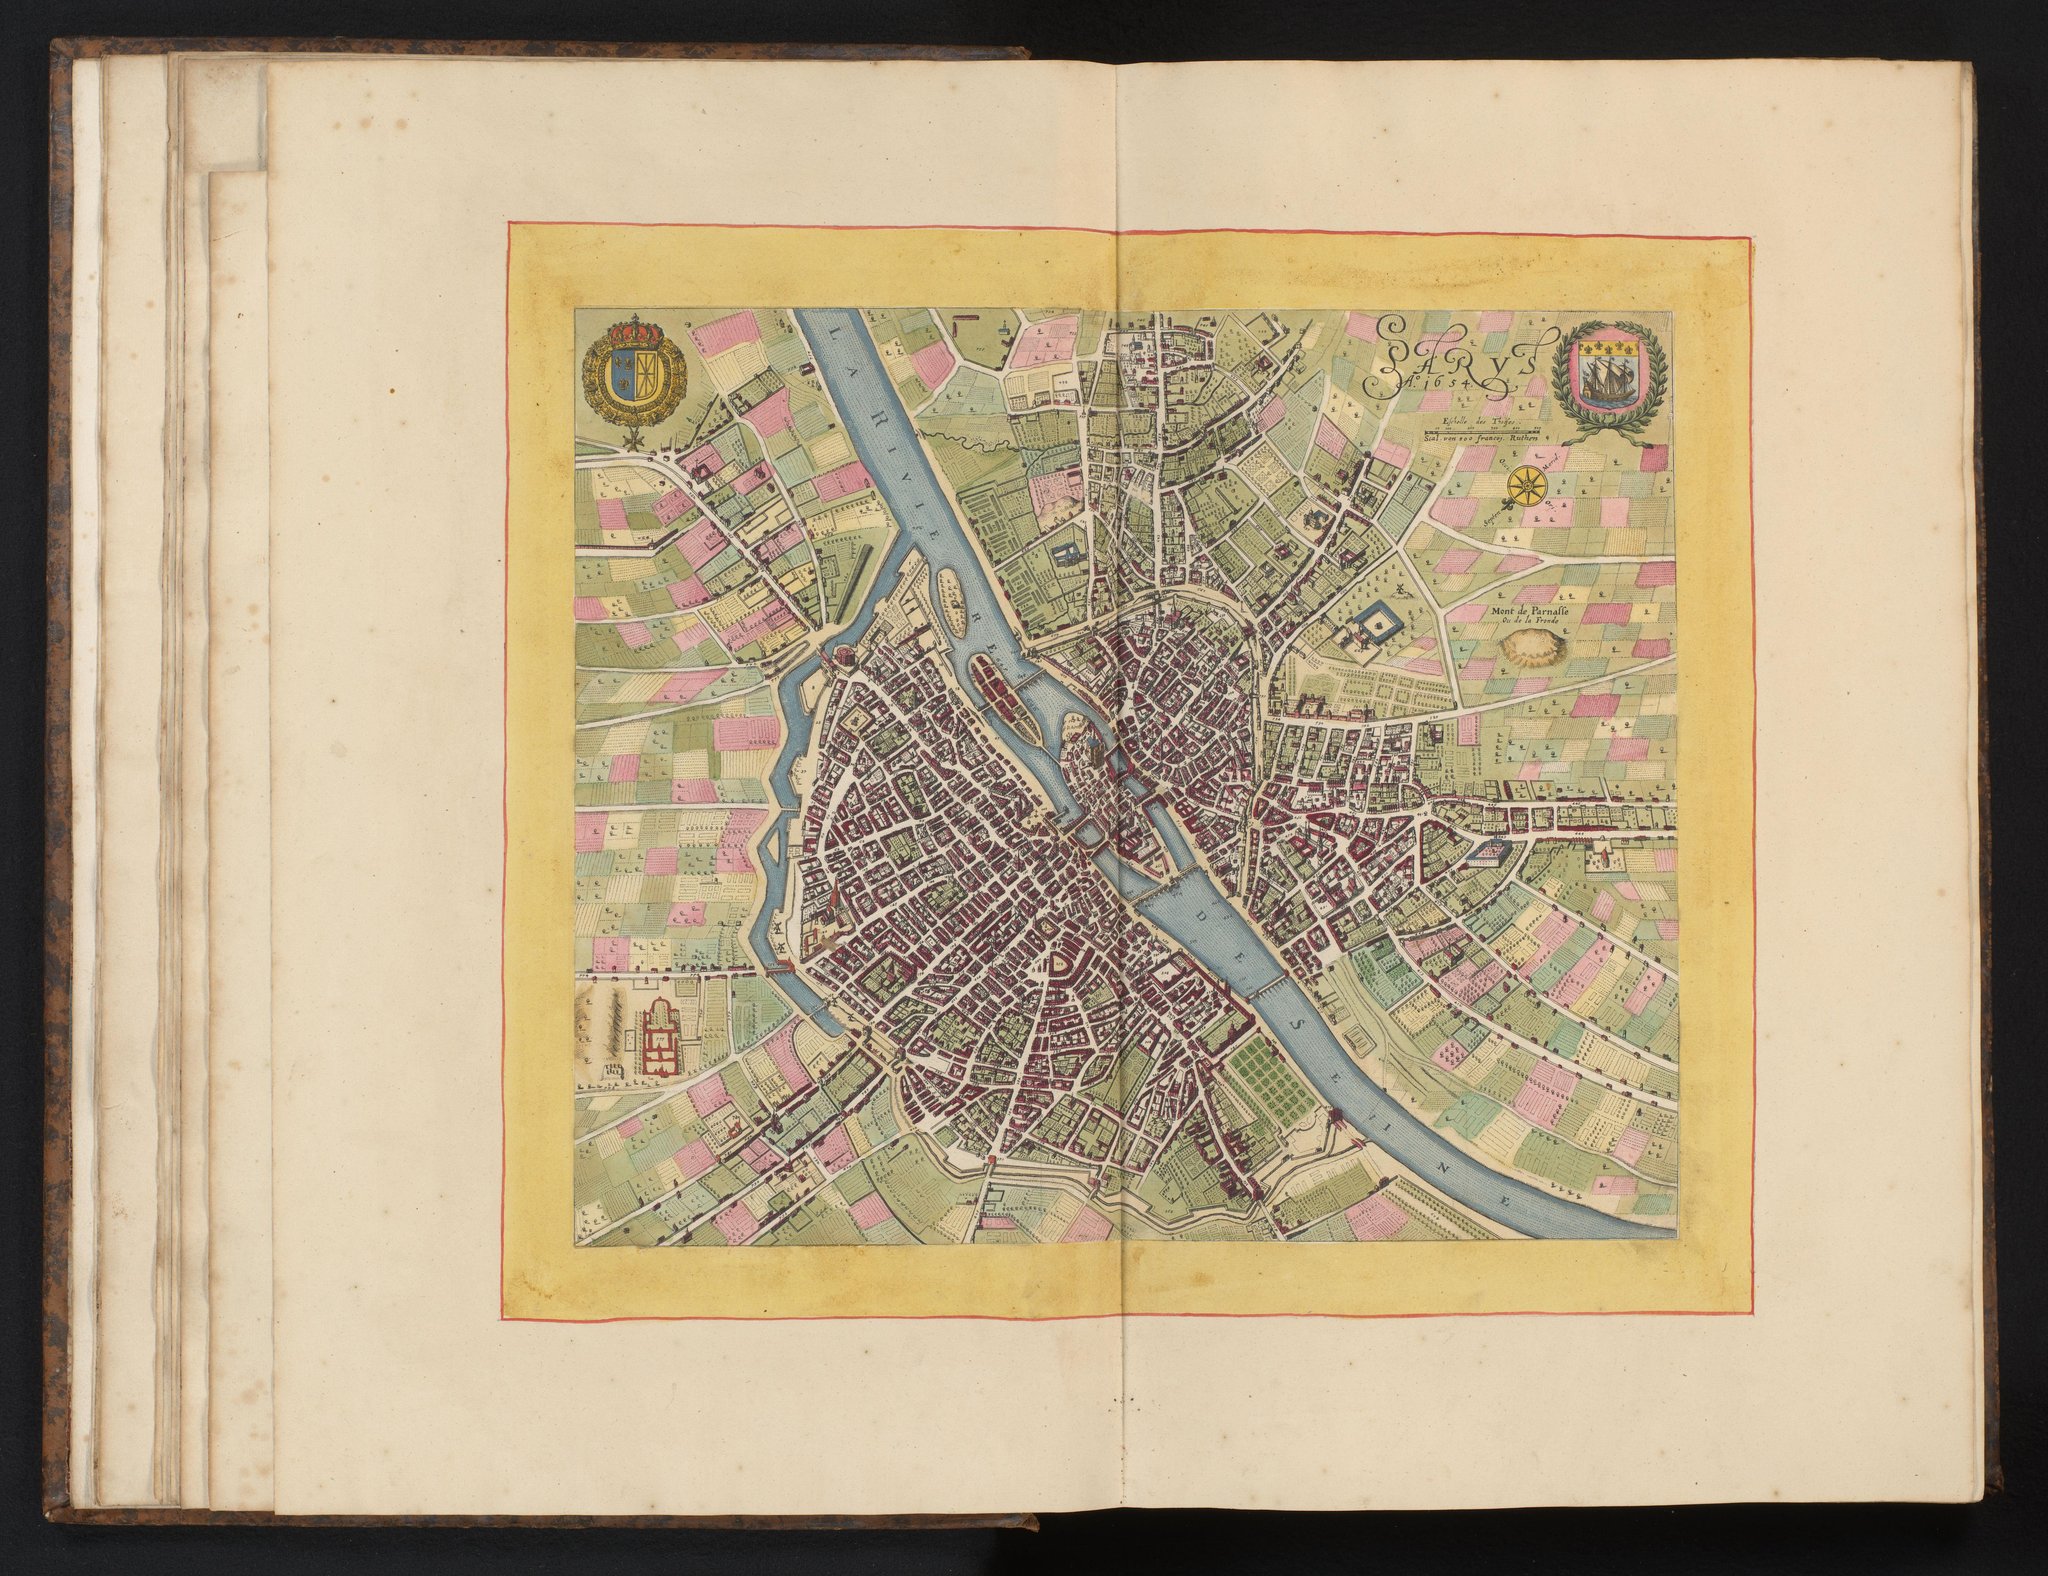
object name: map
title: Kaart van Parijs, 1654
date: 1655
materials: paper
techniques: engraving, hand coloring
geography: paris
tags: maps of cities, paris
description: Prent origineel vervaardigd als boekillustratie voor: Zeiller, Martin. Topographia Galliae, oder Beschreibung und Contrafaitung der vornehmbsten und bekantisten Oerter in dem mächtigen und grossen Königreich Frankreich, 13 delen. Frankfurt am Main: Caspar Merian, 1655-1661. De prent werd voor het eerst gepubliceerd in deel 1: Topographia Galliae, 1655.